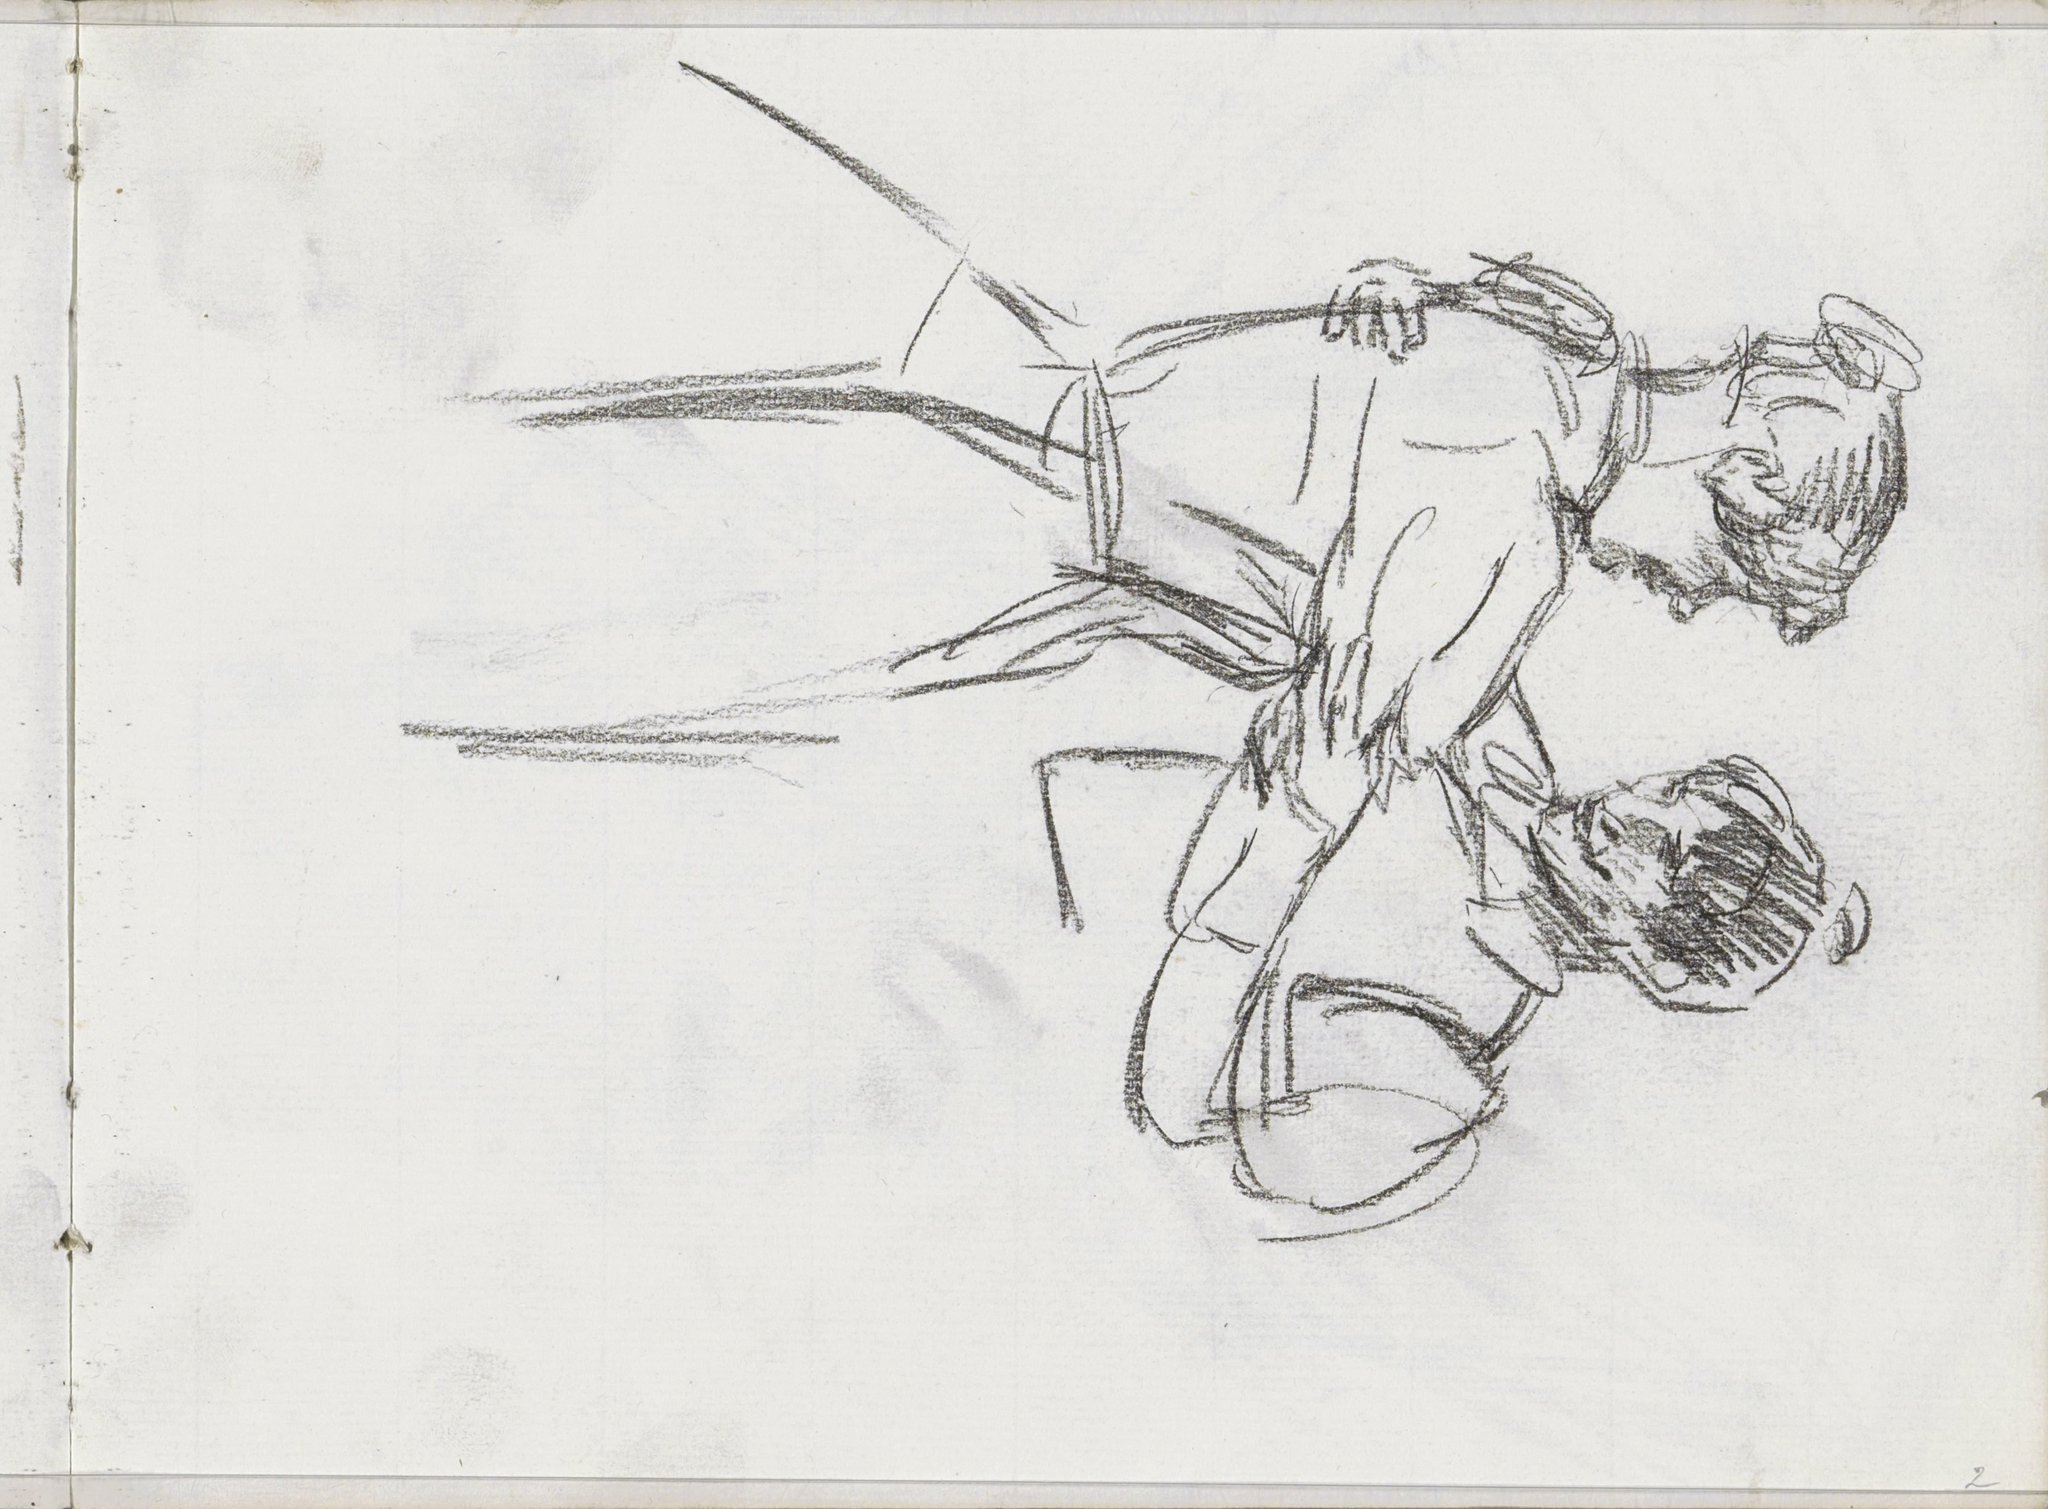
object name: sketchbook leaf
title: Twee elkaar omarmende vrouwen, mogelijk dansend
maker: isaac israels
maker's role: draughtsman, painter, print maker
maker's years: 1865-1934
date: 1875-1934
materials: chalk, paper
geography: amsterdam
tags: dancing, adult woman (+ two persons)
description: Blad 2 recto uit schetsboek XX met 26 bladen.